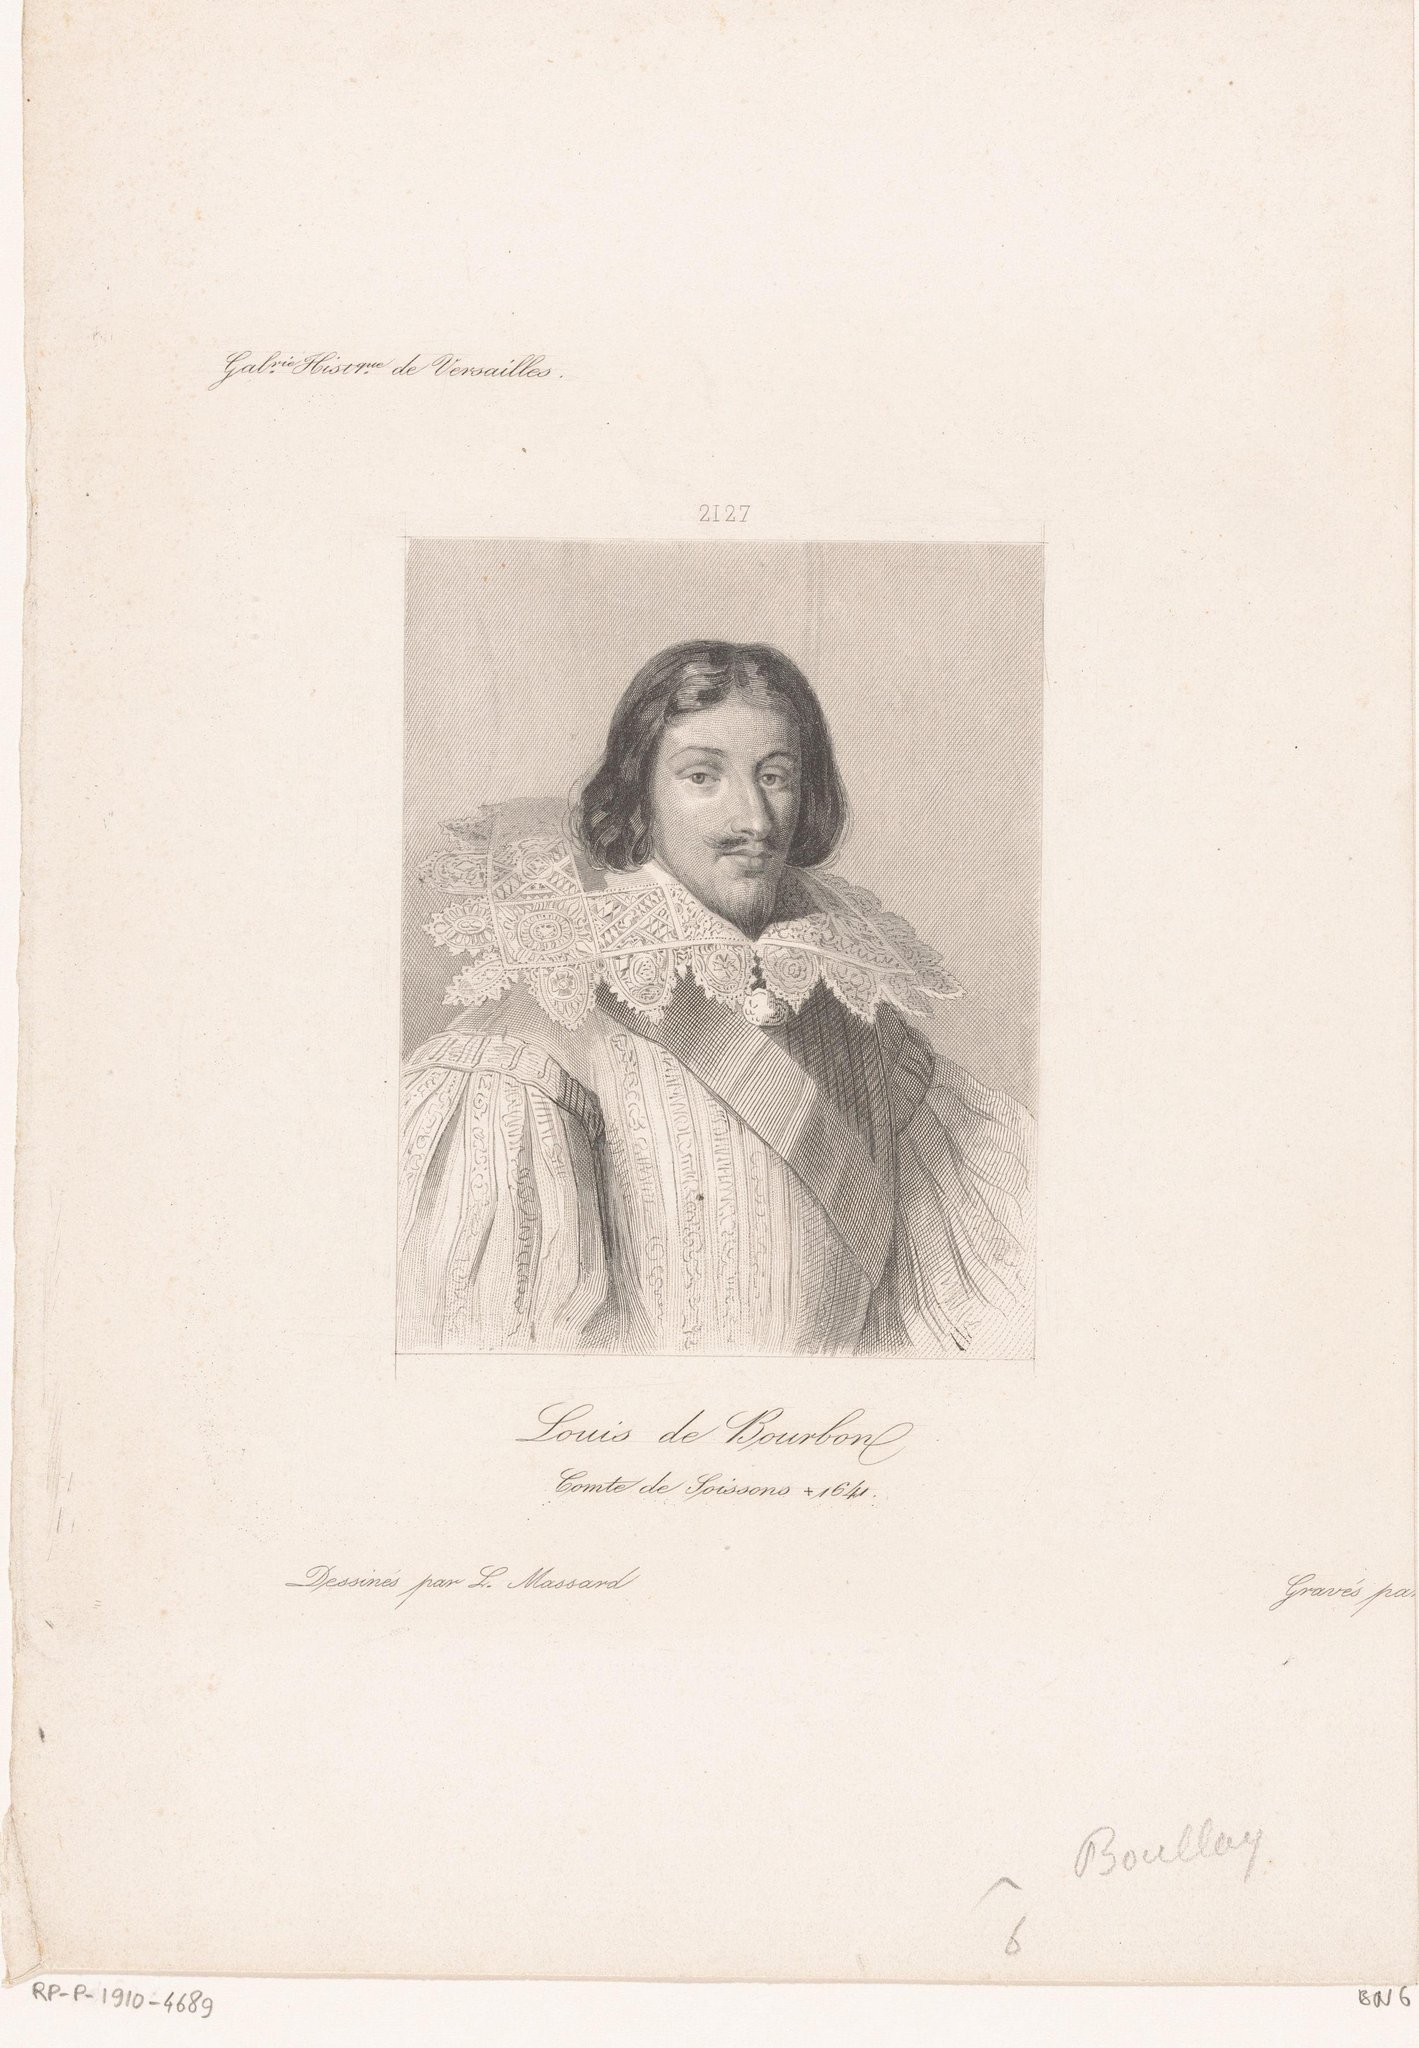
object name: print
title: Portret van Louis de Bourbon, graaf van Soissons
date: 1838-1841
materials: paper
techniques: etching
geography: paris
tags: earl, historical persons, neck-gear: collar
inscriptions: collector's mark: Lugt 2228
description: Prent uit: s.n. Galeries historiques de Versailles. Parijs: Charles Gavard, 1838-1841, p. 109.